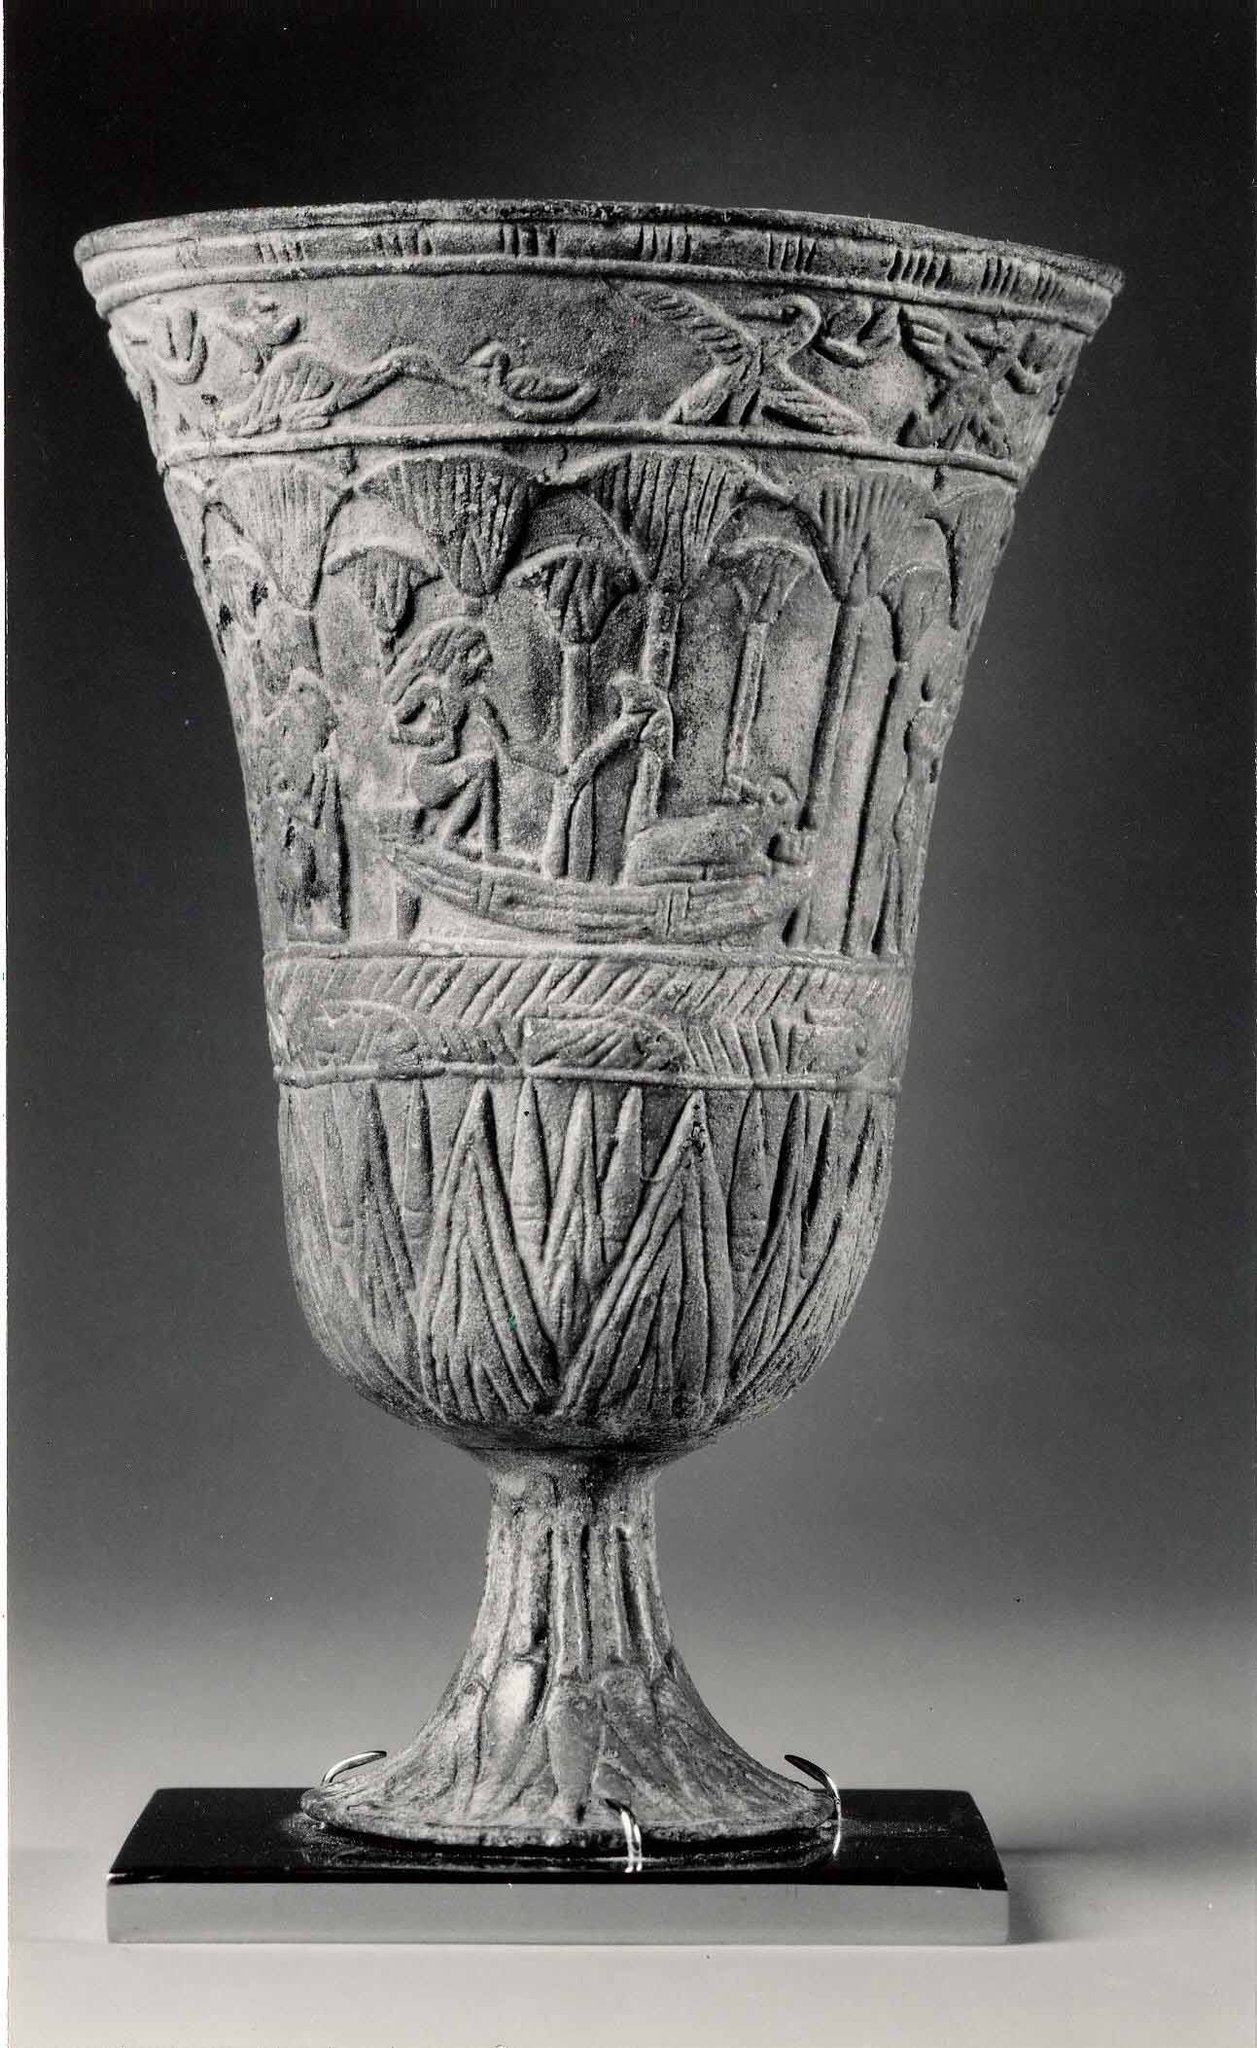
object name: chalice, cup, lotiform, relief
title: Chalice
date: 945-712 BCE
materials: faience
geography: egypt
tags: human figures,birds,fish,boats